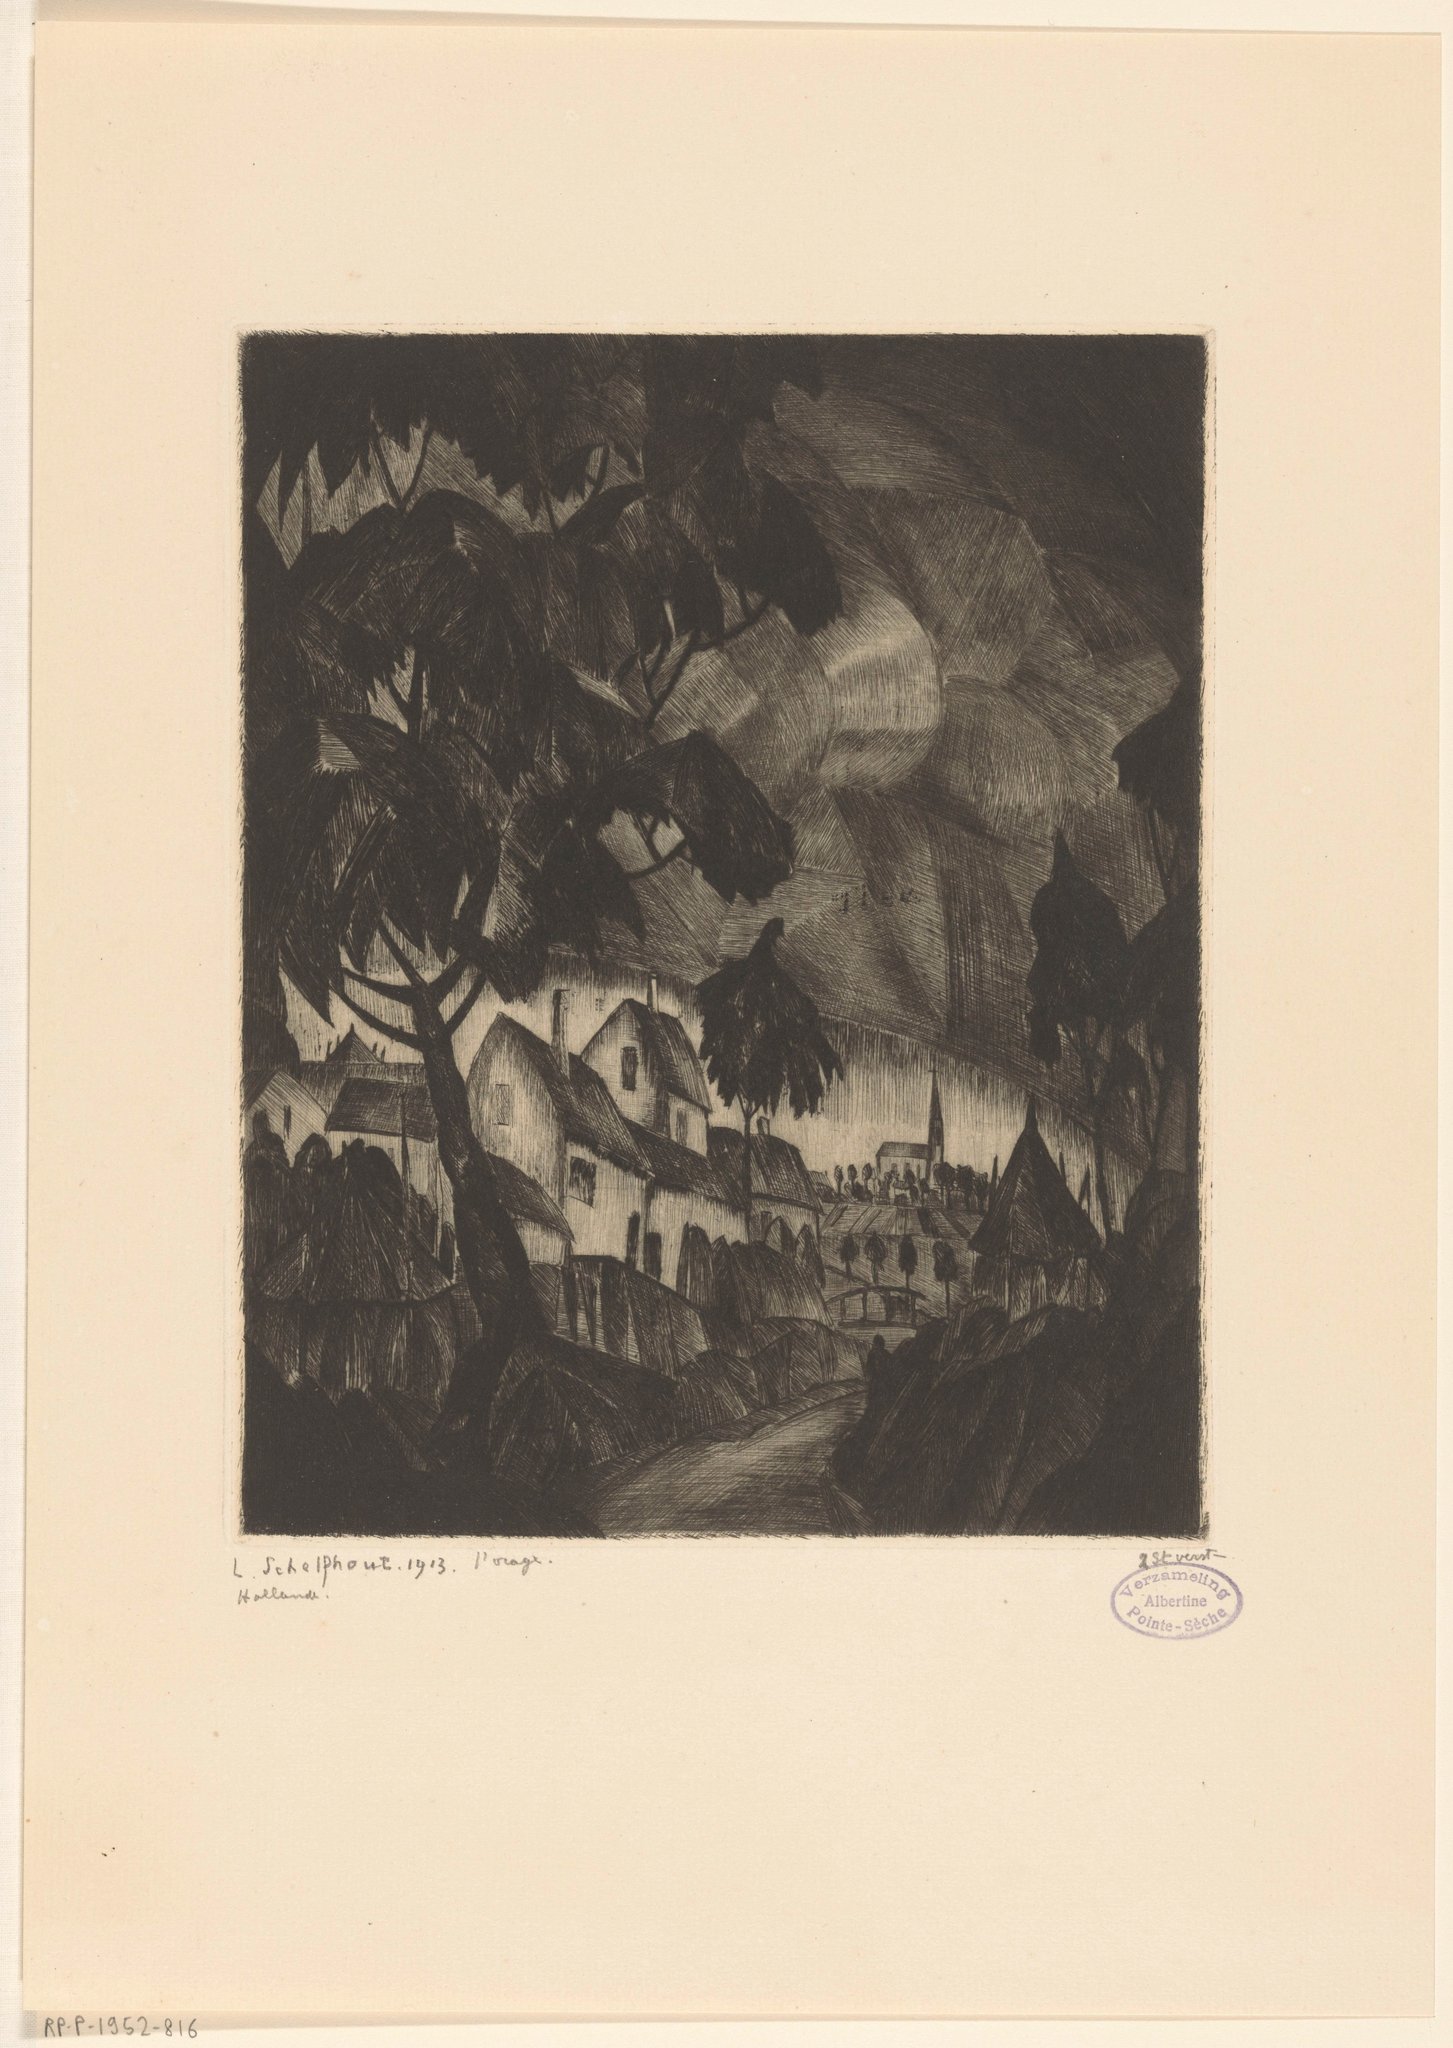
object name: print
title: L'Orage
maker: lodewijk schelfhout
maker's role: draughtsman, print maker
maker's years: 1881-1943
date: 1913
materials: paper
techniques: drypoint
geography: netherlands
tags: low hill country, thunderstorm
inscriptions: collector's mark: Lugt 5i, collector's mark: Lugt 2228, collector's mark: Lugt 2760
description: Een zwaarbewolkte lucht boven een heuvellandschap met bomen en huizen.